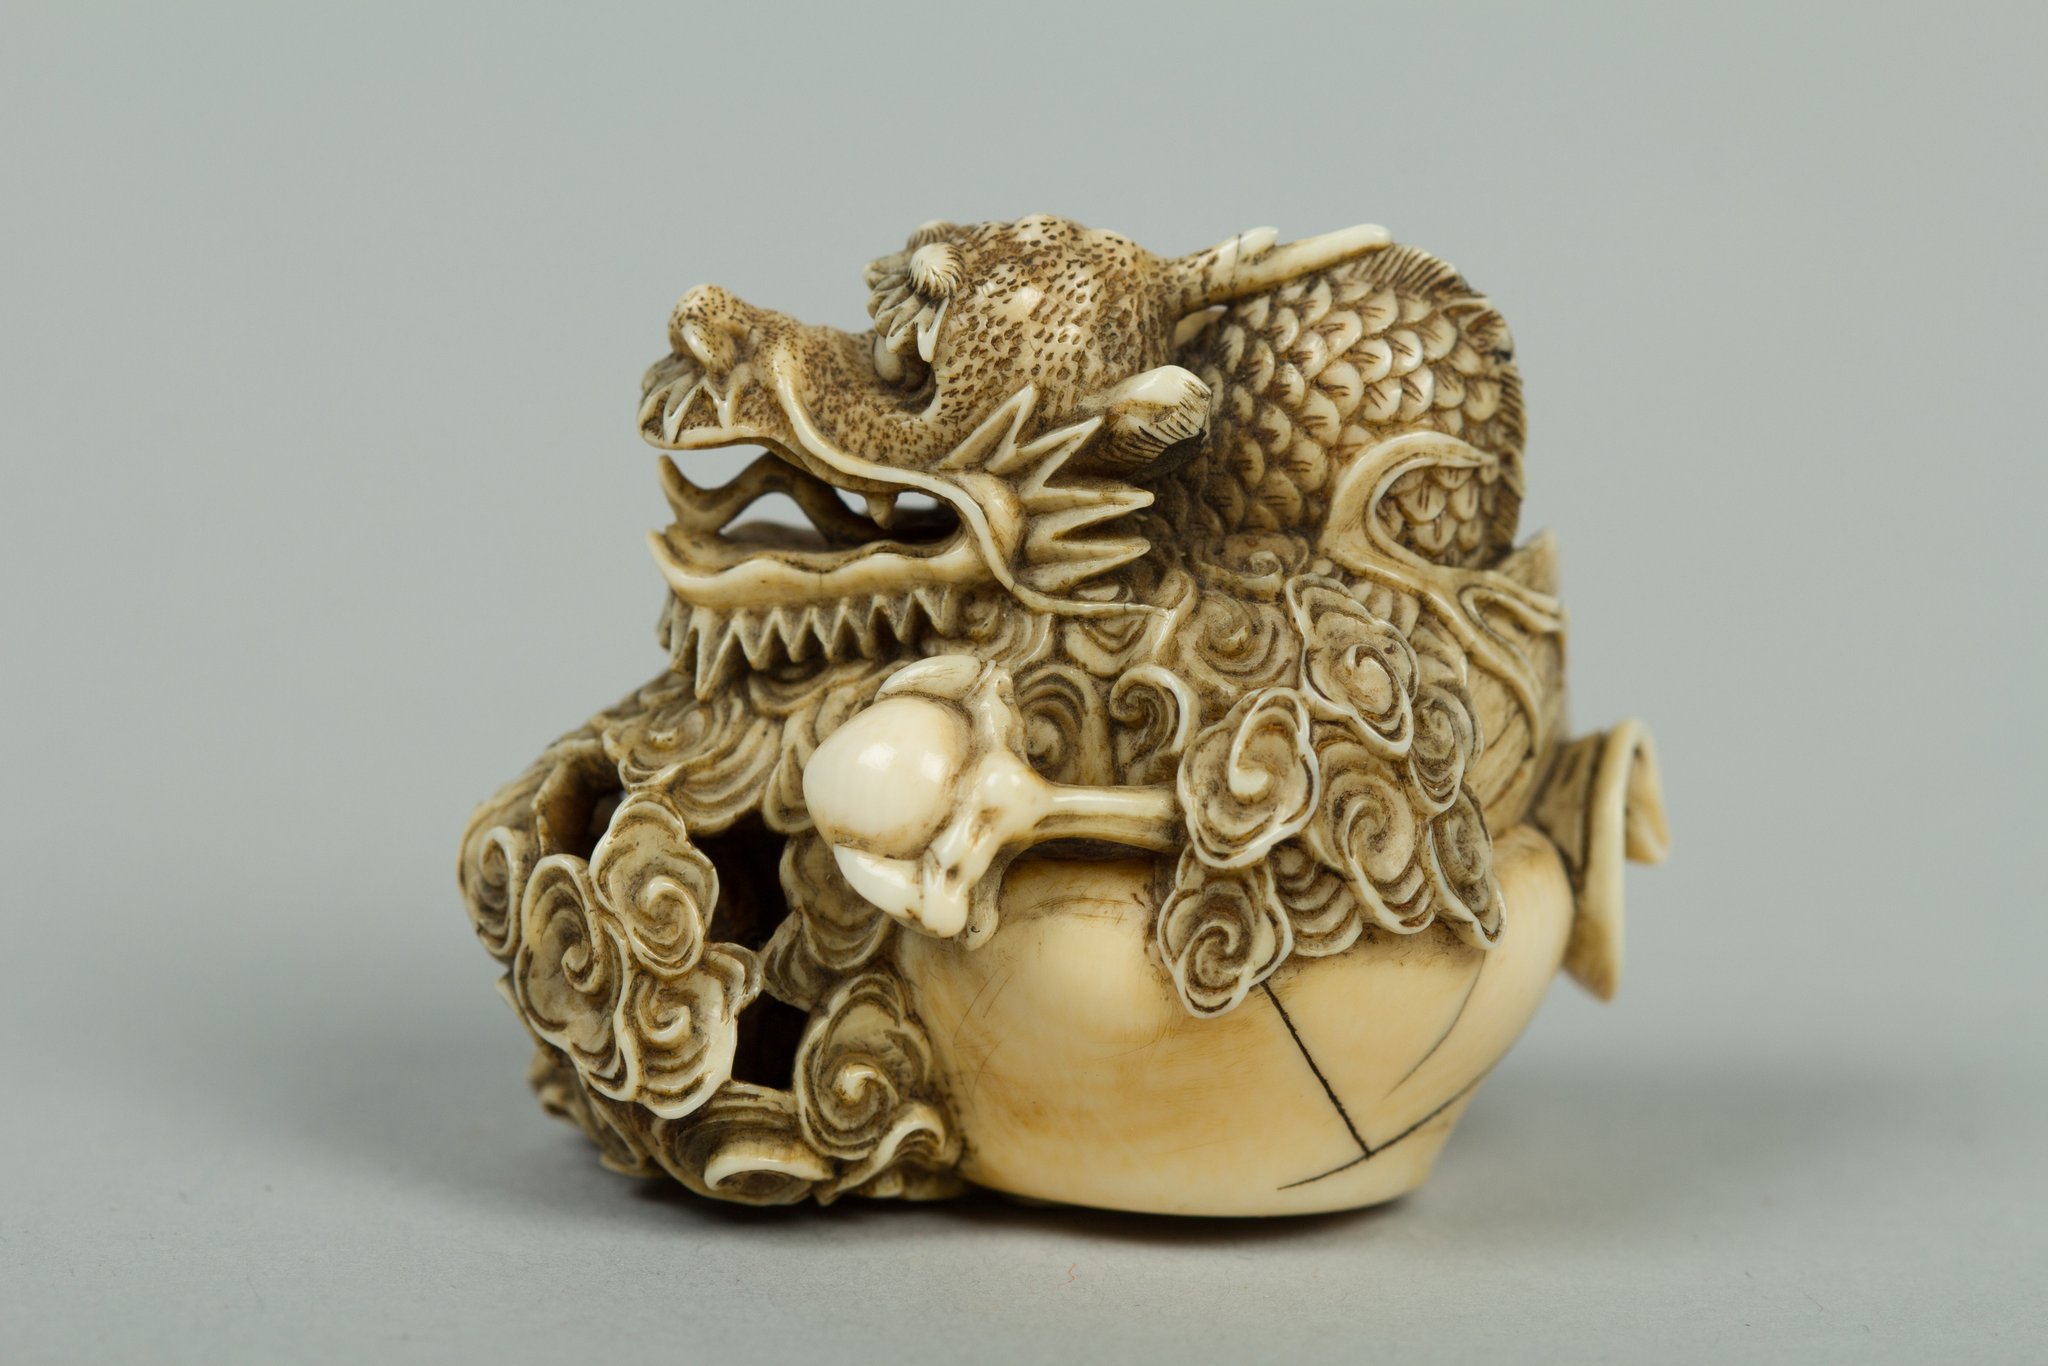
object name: netsuke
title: Jewel-Holding Dragon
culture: japanese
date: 1701-1800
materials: ivory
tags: dragons